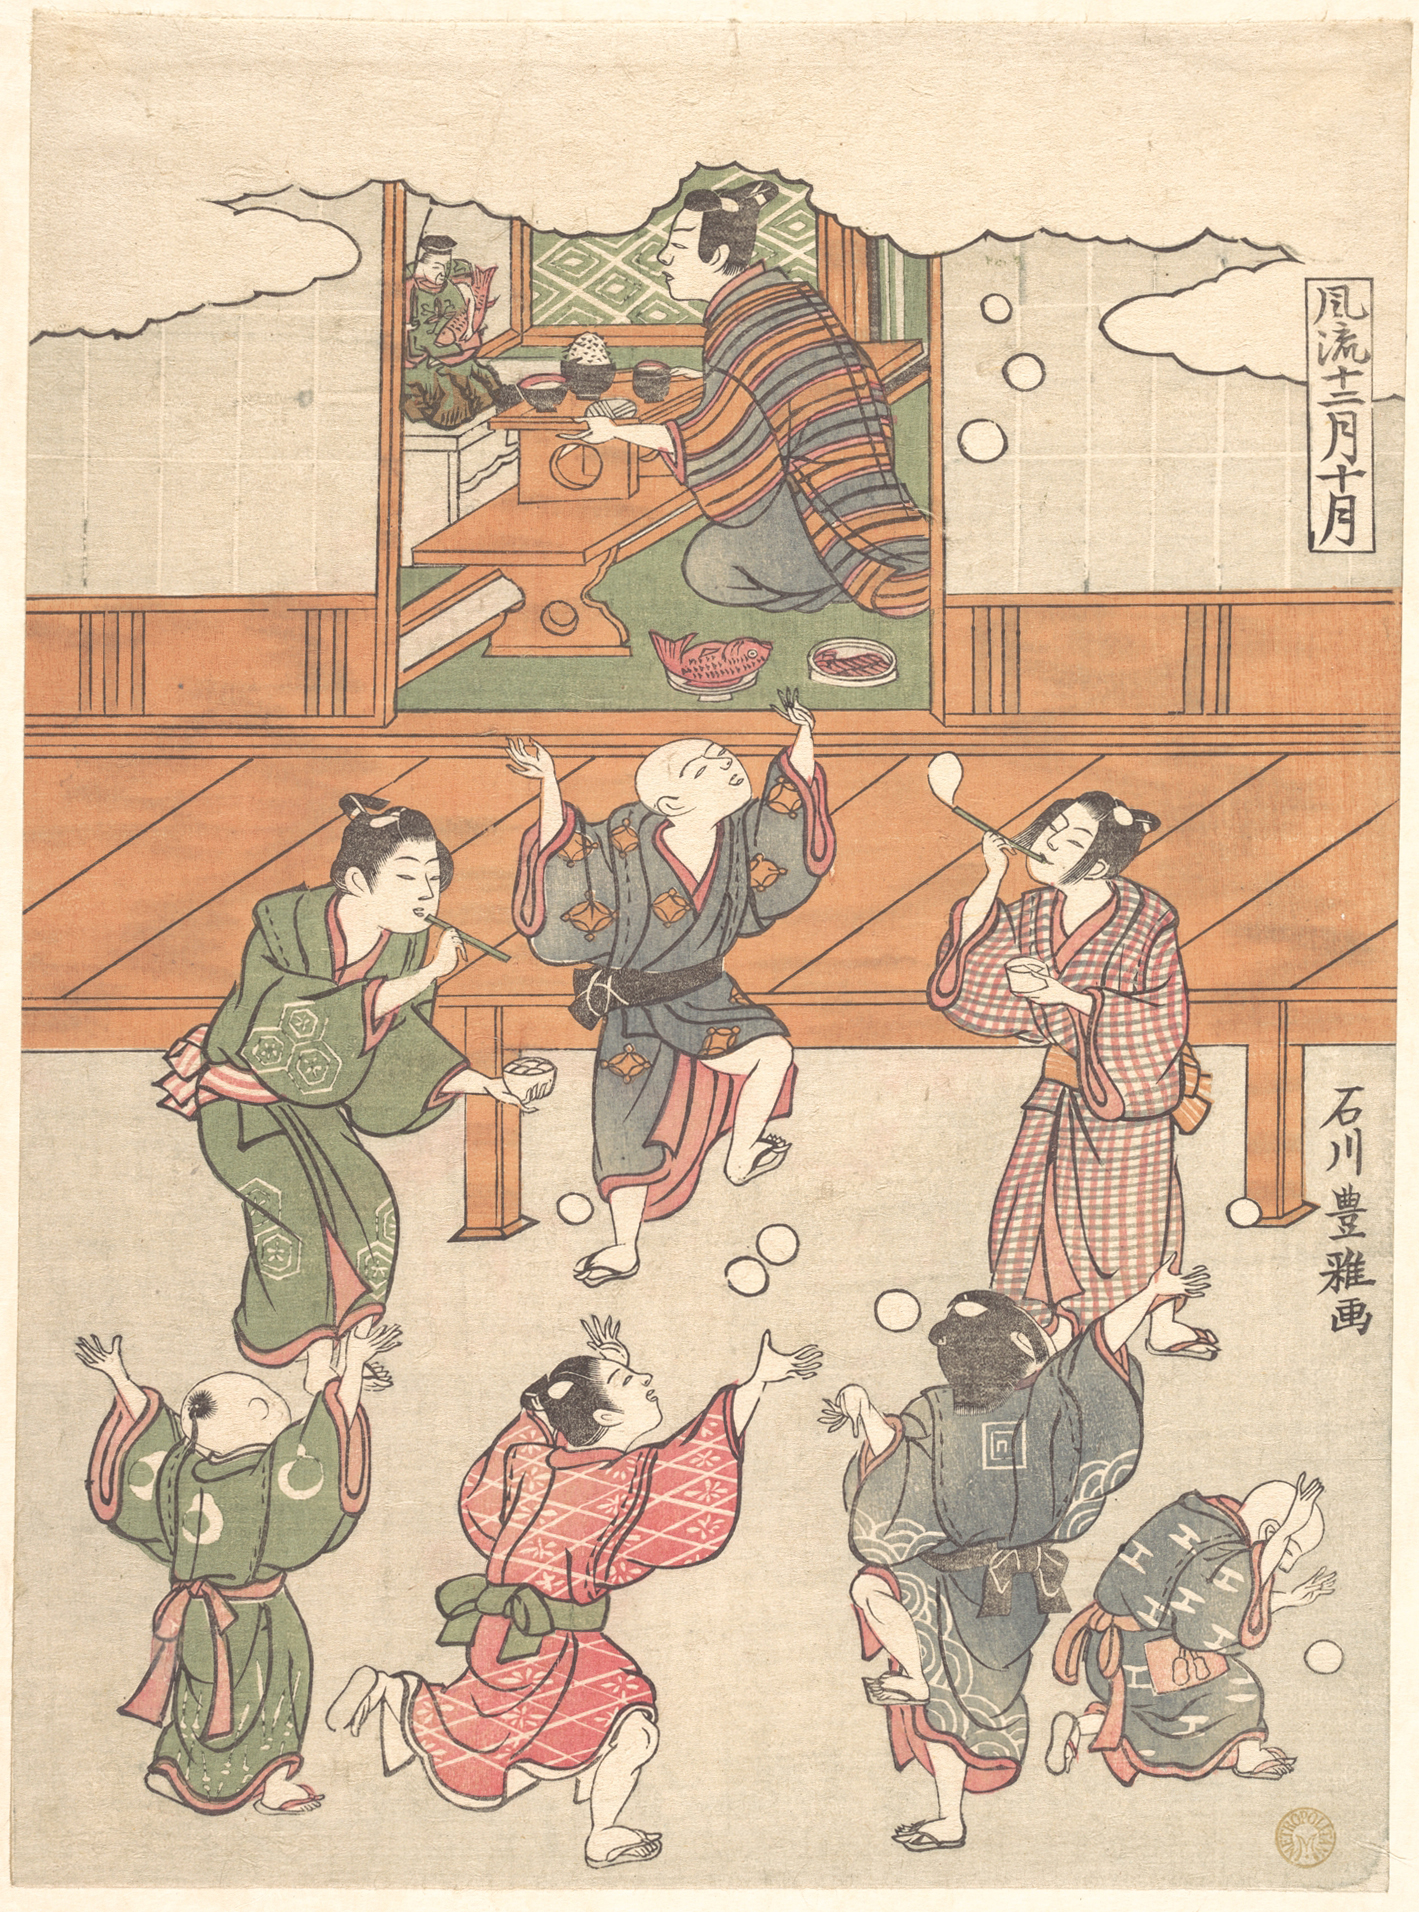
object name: print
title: The Tenth Month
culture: japanese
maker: ishikawa toyomasa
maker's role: artist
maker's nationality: japanese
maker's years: 1770-1790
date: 1767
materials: ink, paper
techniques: woodblock print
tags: boys,girls,men,women,playing